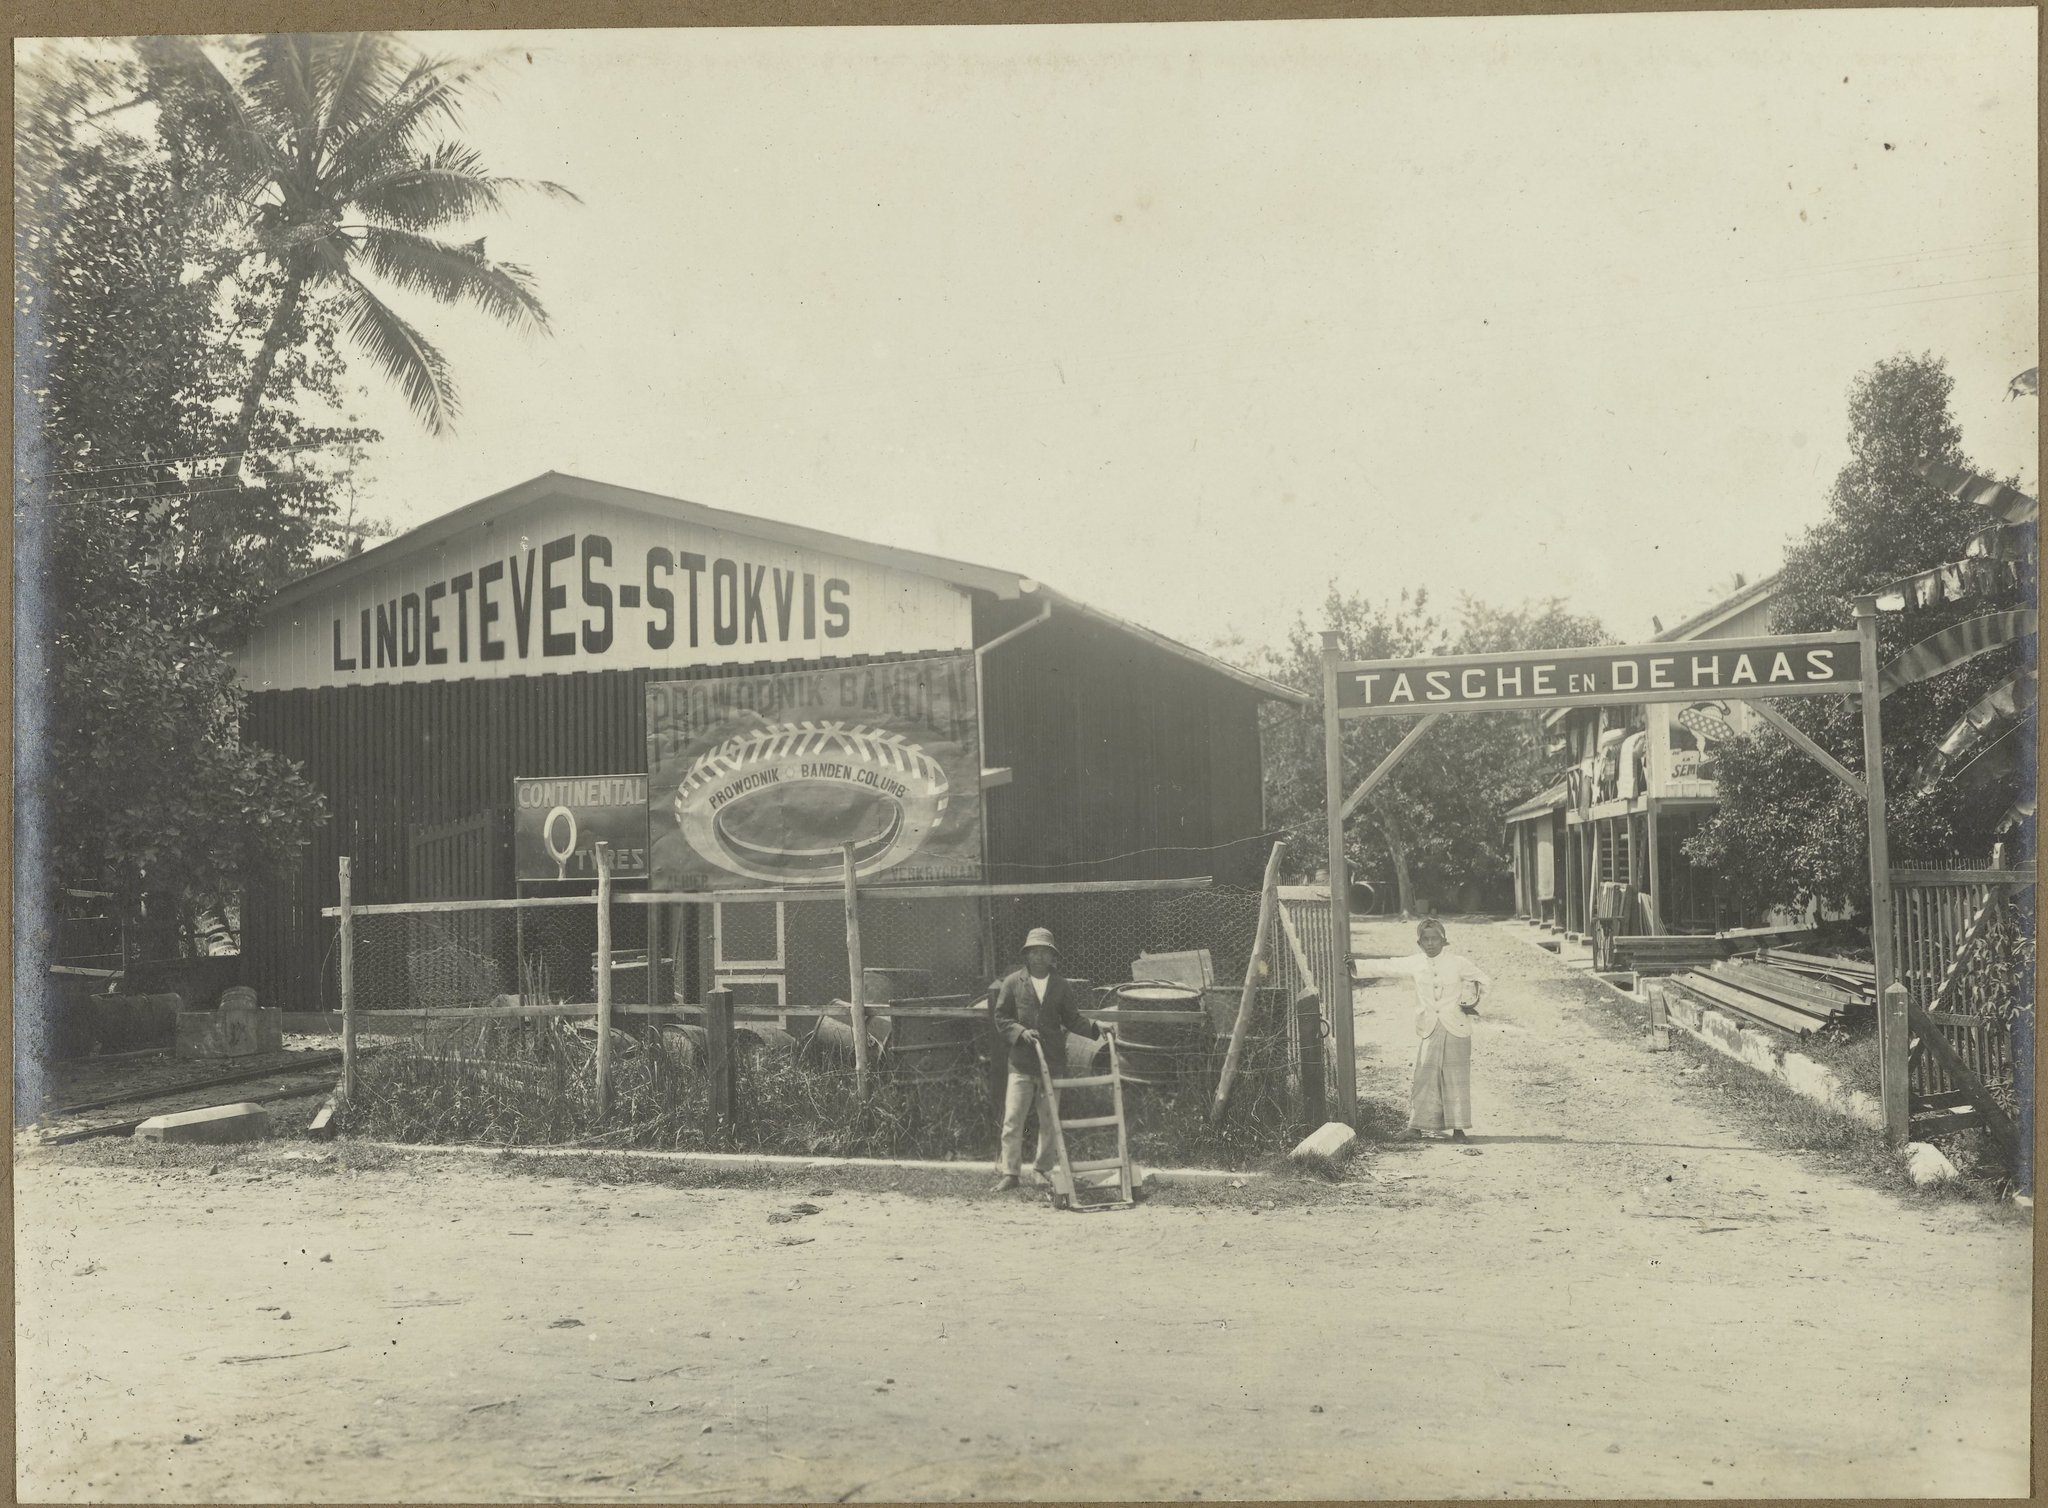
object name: photograph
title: Lokale bedrijven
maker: Anonymous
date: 1914-1919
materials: photographic support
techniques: gelatin silver print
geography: medan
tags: representation of real building (either existing or having existed), architecture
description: Twee lokale bedrijven van Europeanen genaamd Lindeteves-Stokvis (autobanden) en Tasche en De Haas, waarschijnlijk te Medan. Foto in het fotoalbum van het Nederlandse architectenbureau en aannemersbedrijf Bennink en Riphagen te Medan in de jaren ca. 1914-1919.